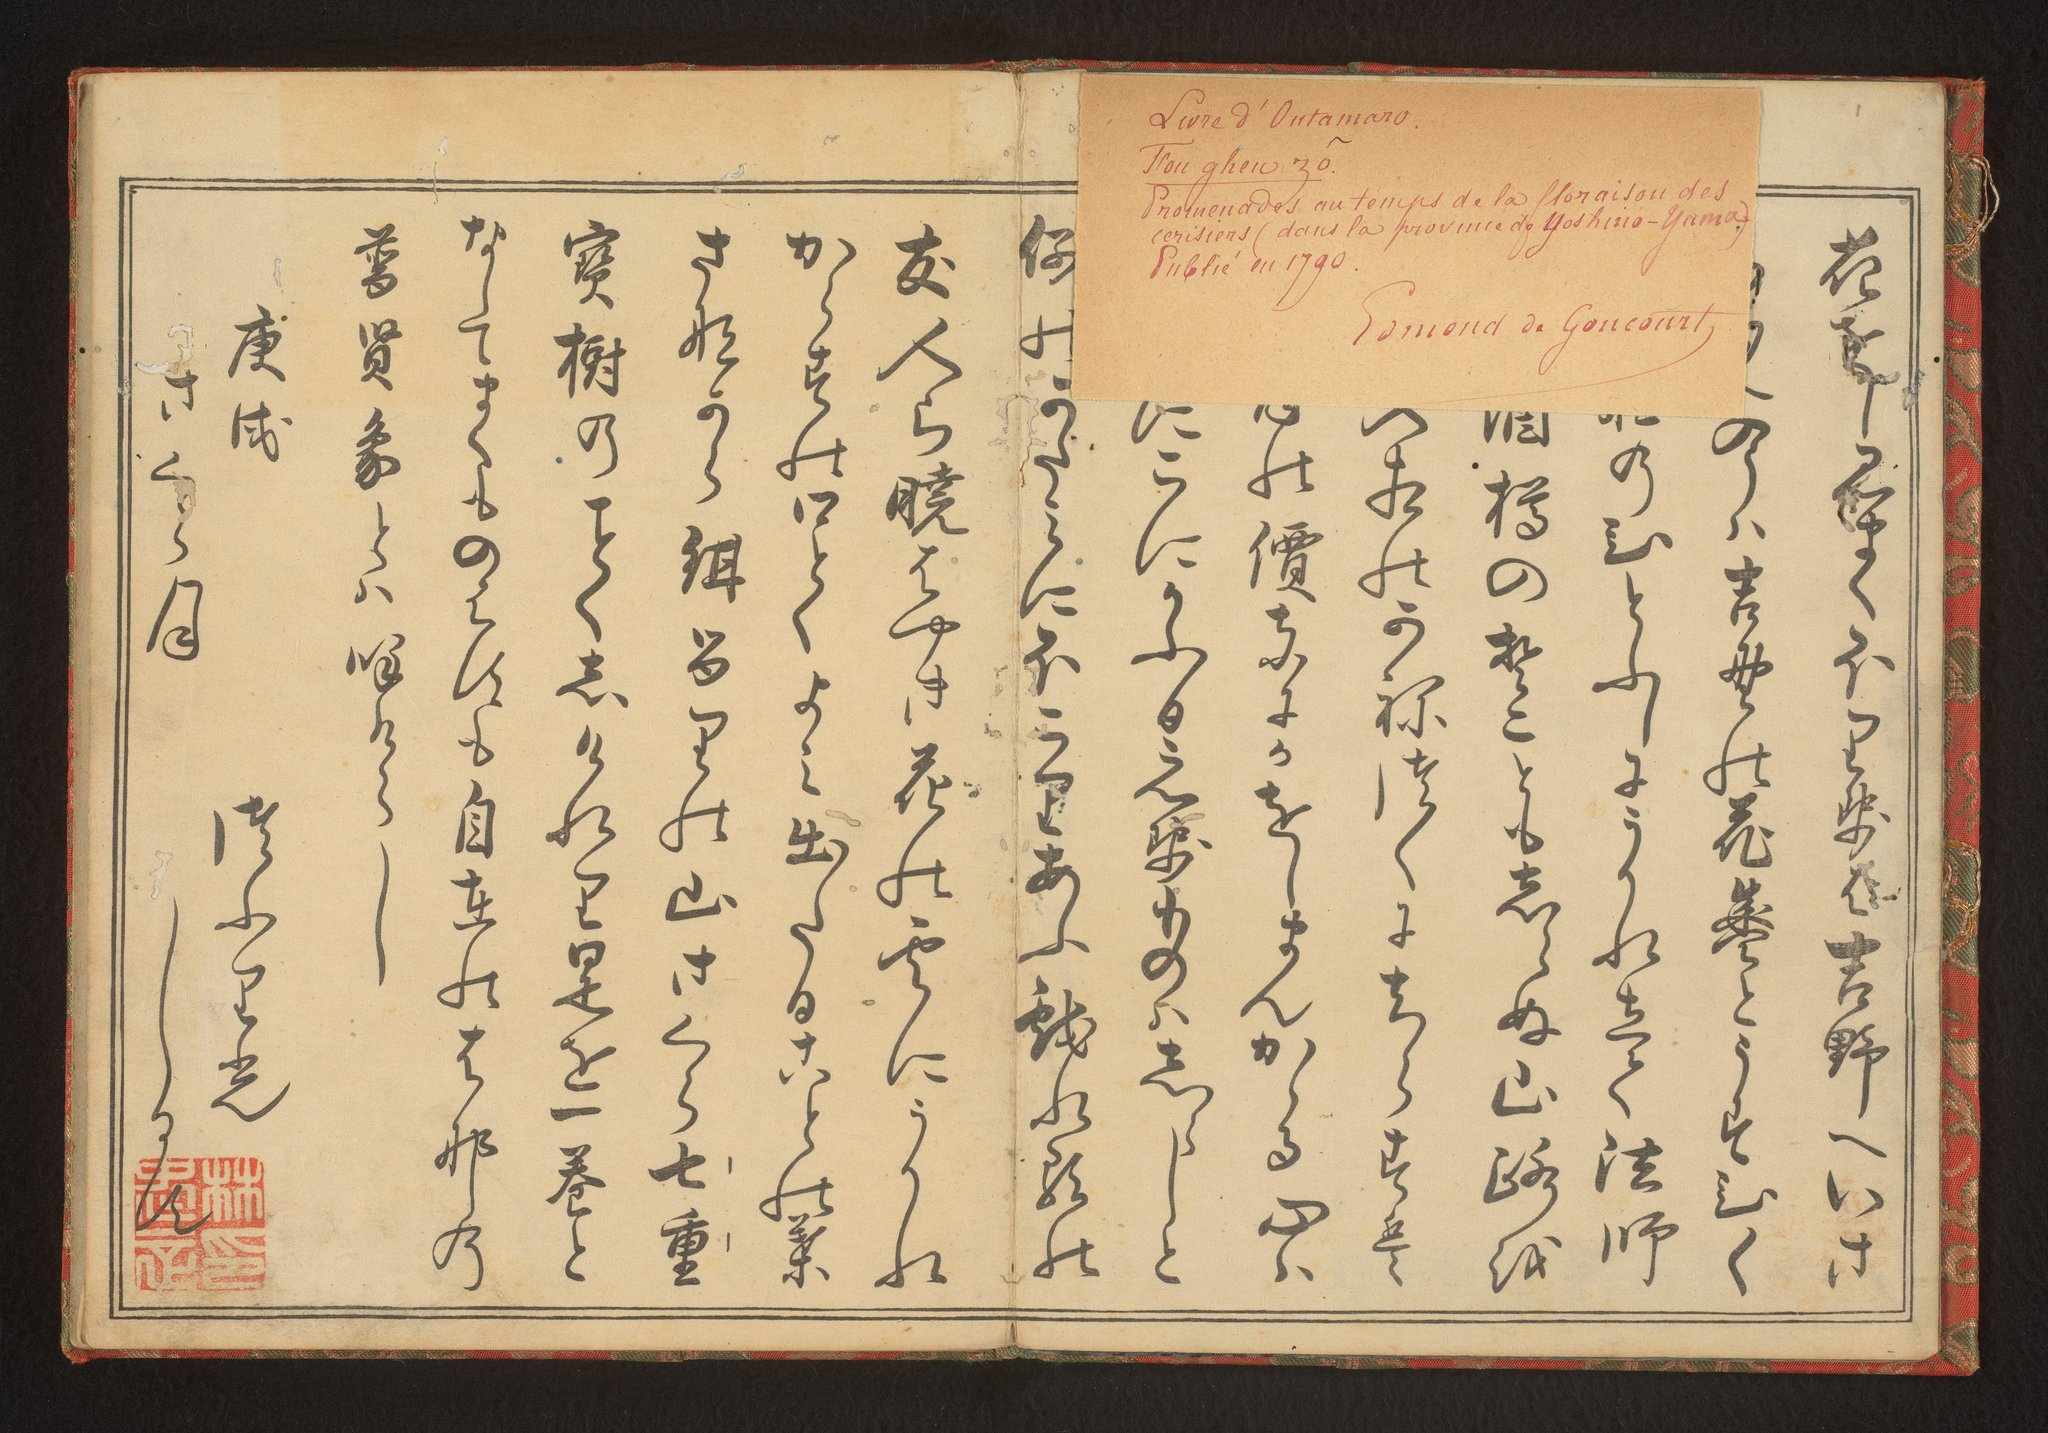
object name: page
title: Preface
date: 1790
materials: paper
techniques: woodcut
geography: edo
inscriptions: date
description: Eerste en tweede pagina uit het boek Fugenzo van Utamaro. Ingeplakt: een handgeschreven notitie van de verzamelaar Edmond de Goncourt.